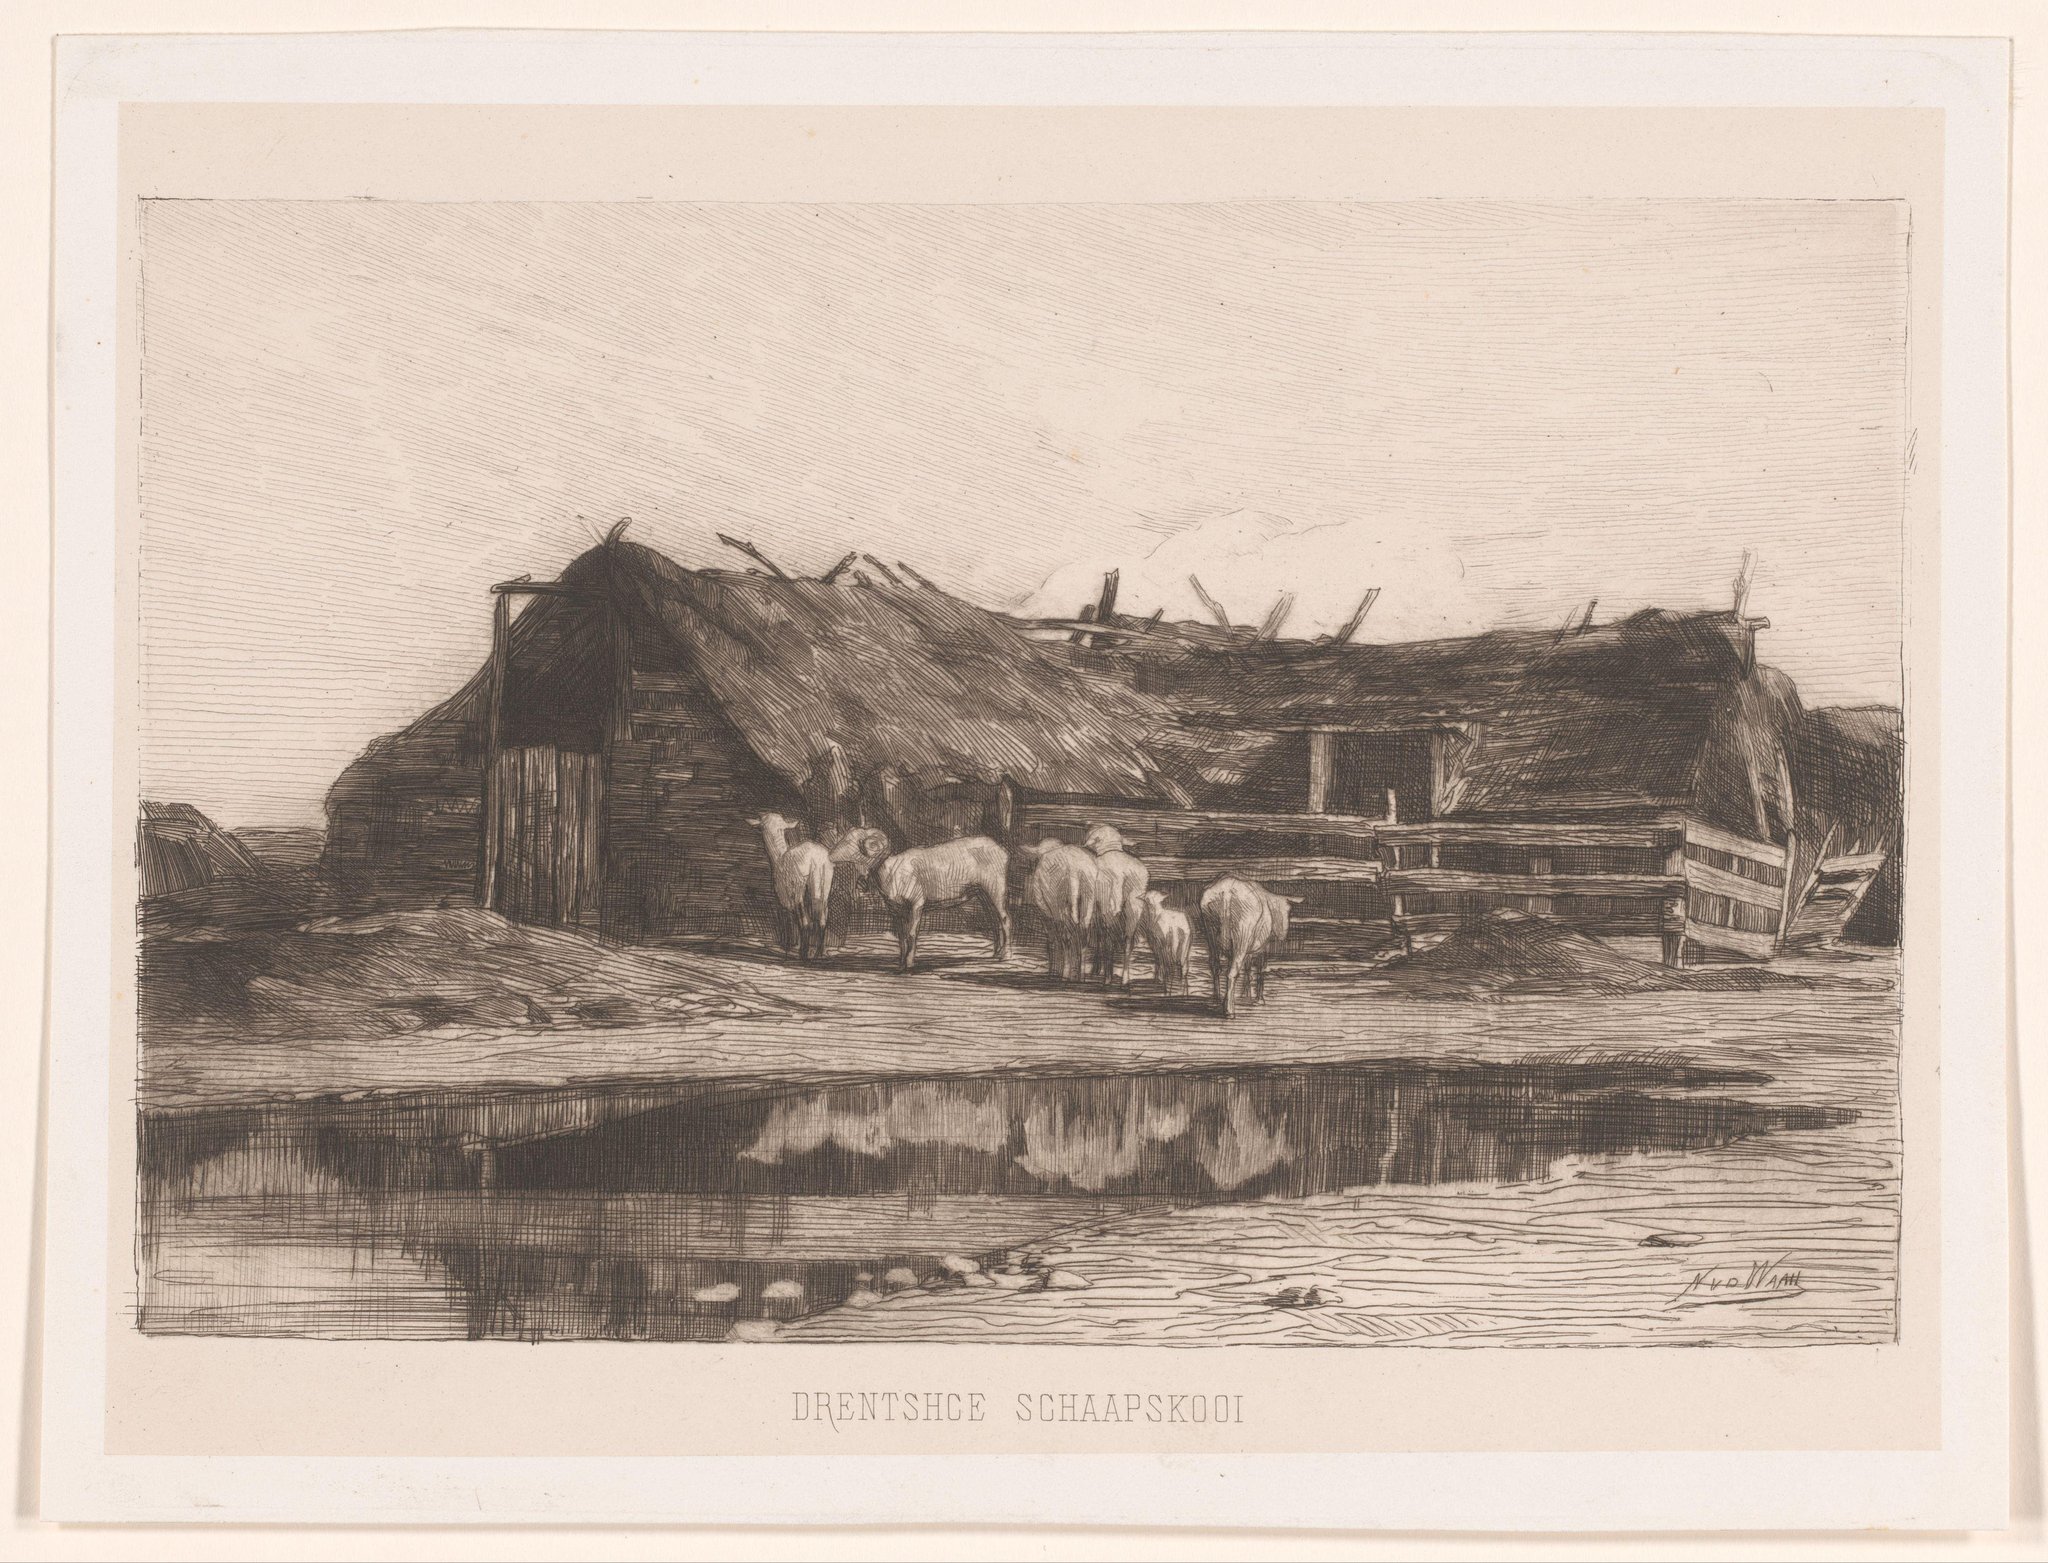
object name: print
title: Drentse schaapskooi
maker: nicolaas van der waay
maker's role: draughtsman, painter, print maker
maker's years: 1855-1936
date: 1865-1936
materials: paper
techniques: drypoint, etching, intaglio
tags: piglet, suckling pig, stall, stable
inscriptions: inscription: ‘distel 1886’, collector's mark: Lugt 2228